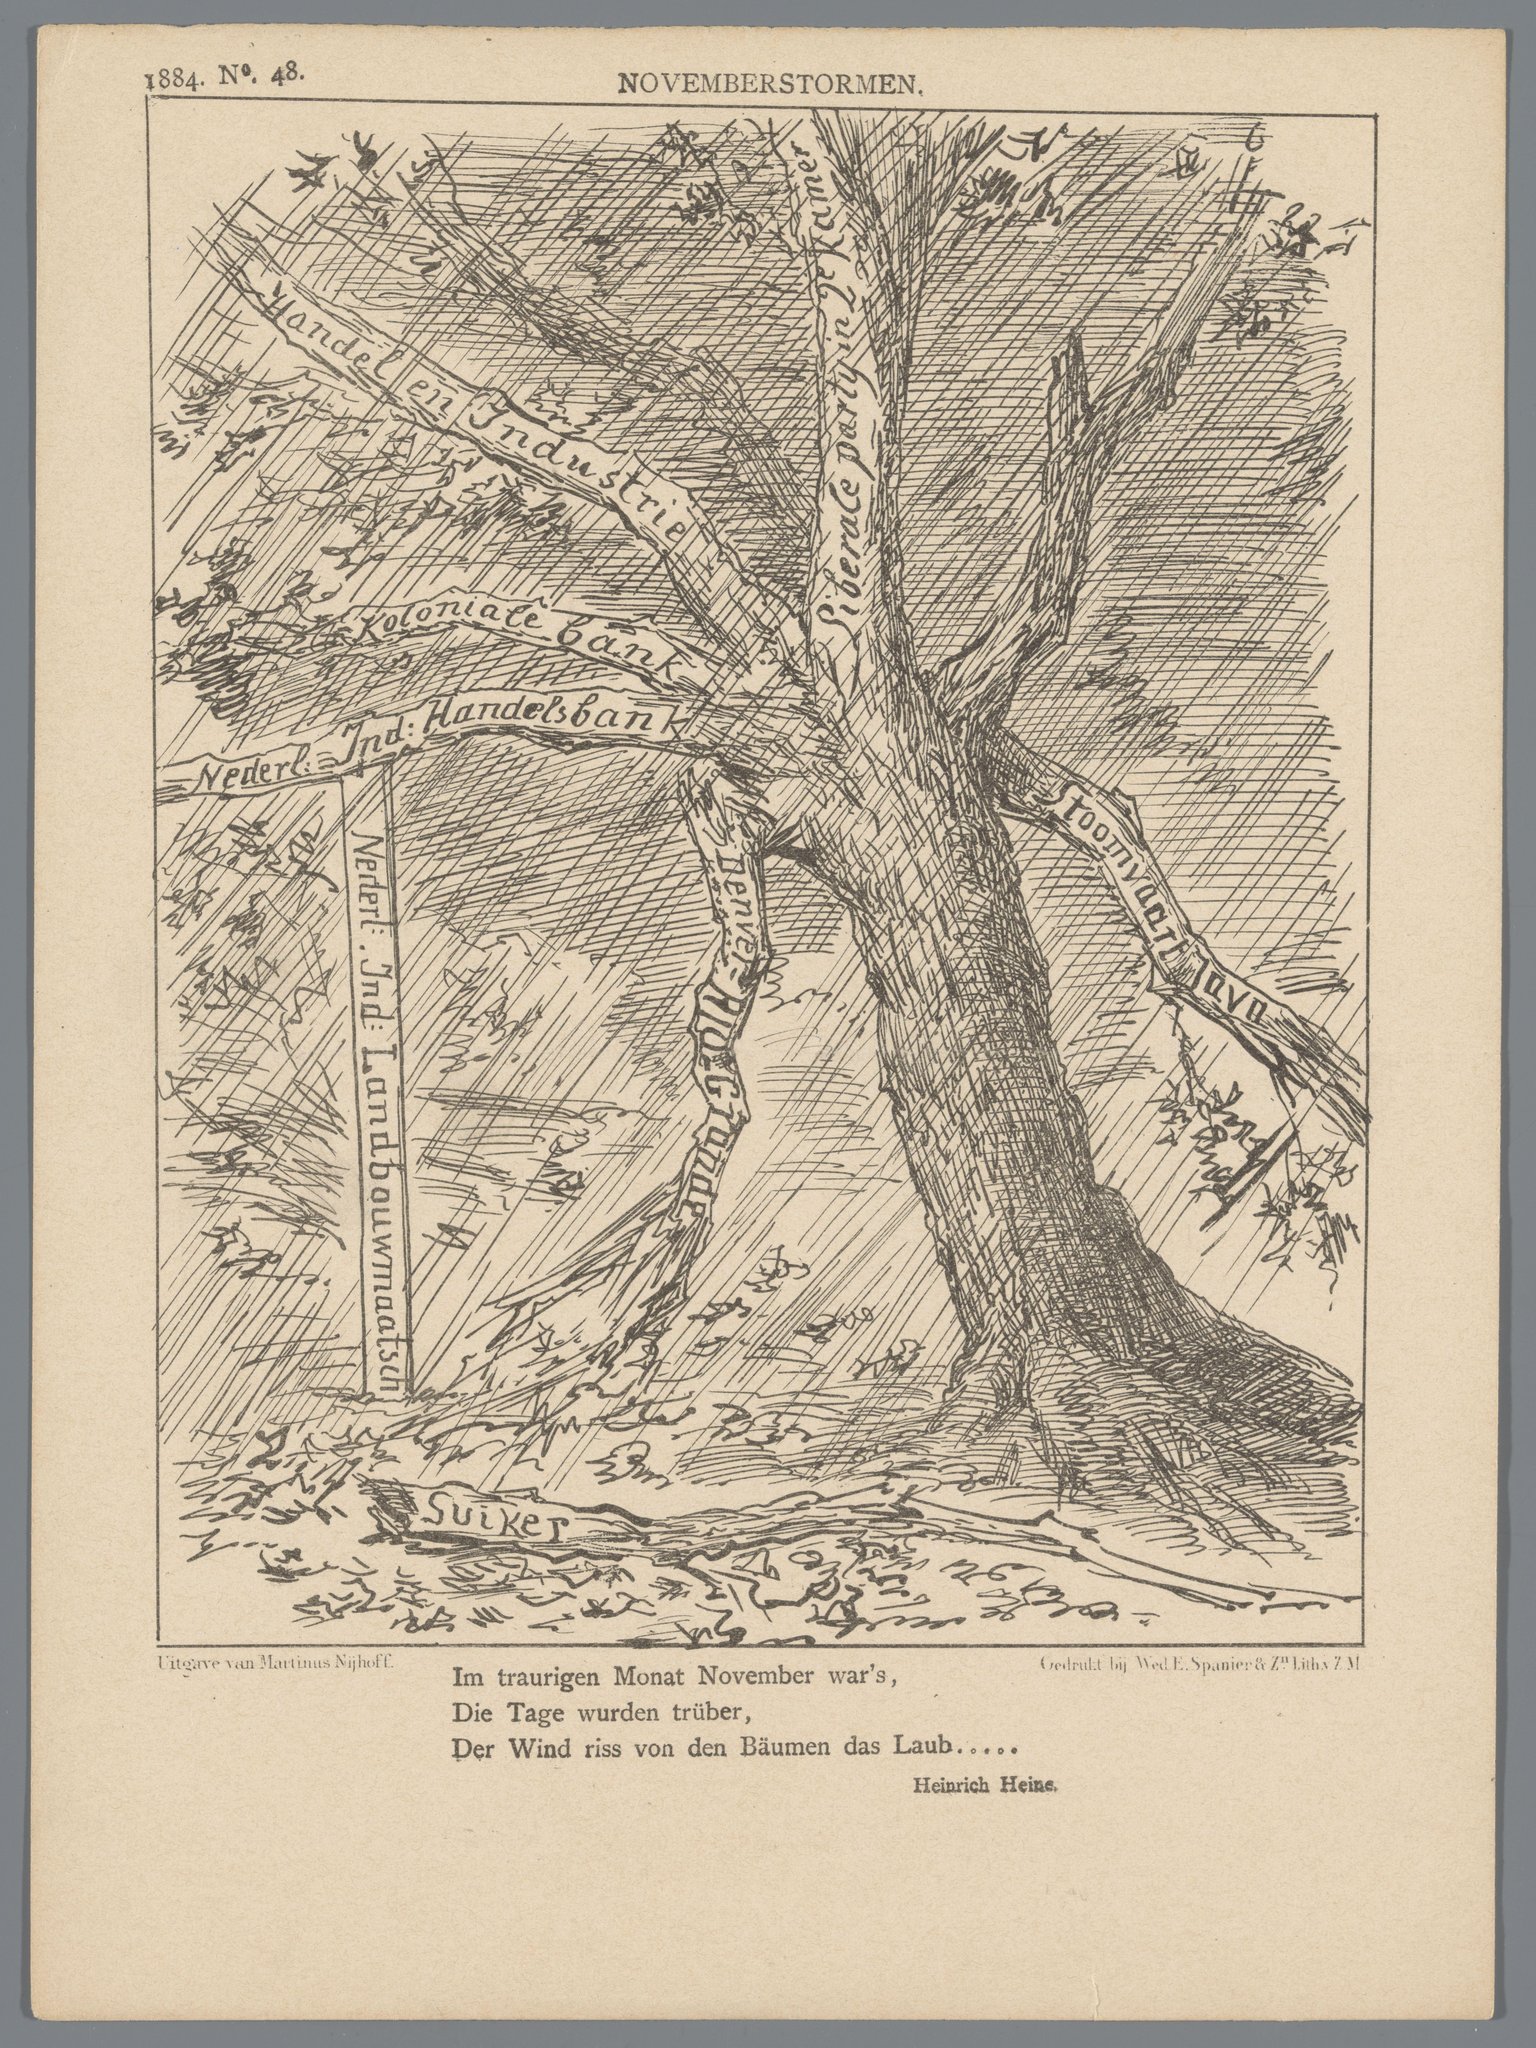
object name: print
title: Spotprent over de politieke problemen, 1884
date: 1884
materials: paper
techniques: lithograph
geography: netherlands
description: Spotprent over de politieke problemen in het land in november 1884. Plaat verschenen bij het weekblad De Nederlandsche Spectator, nr. 48, 1884.